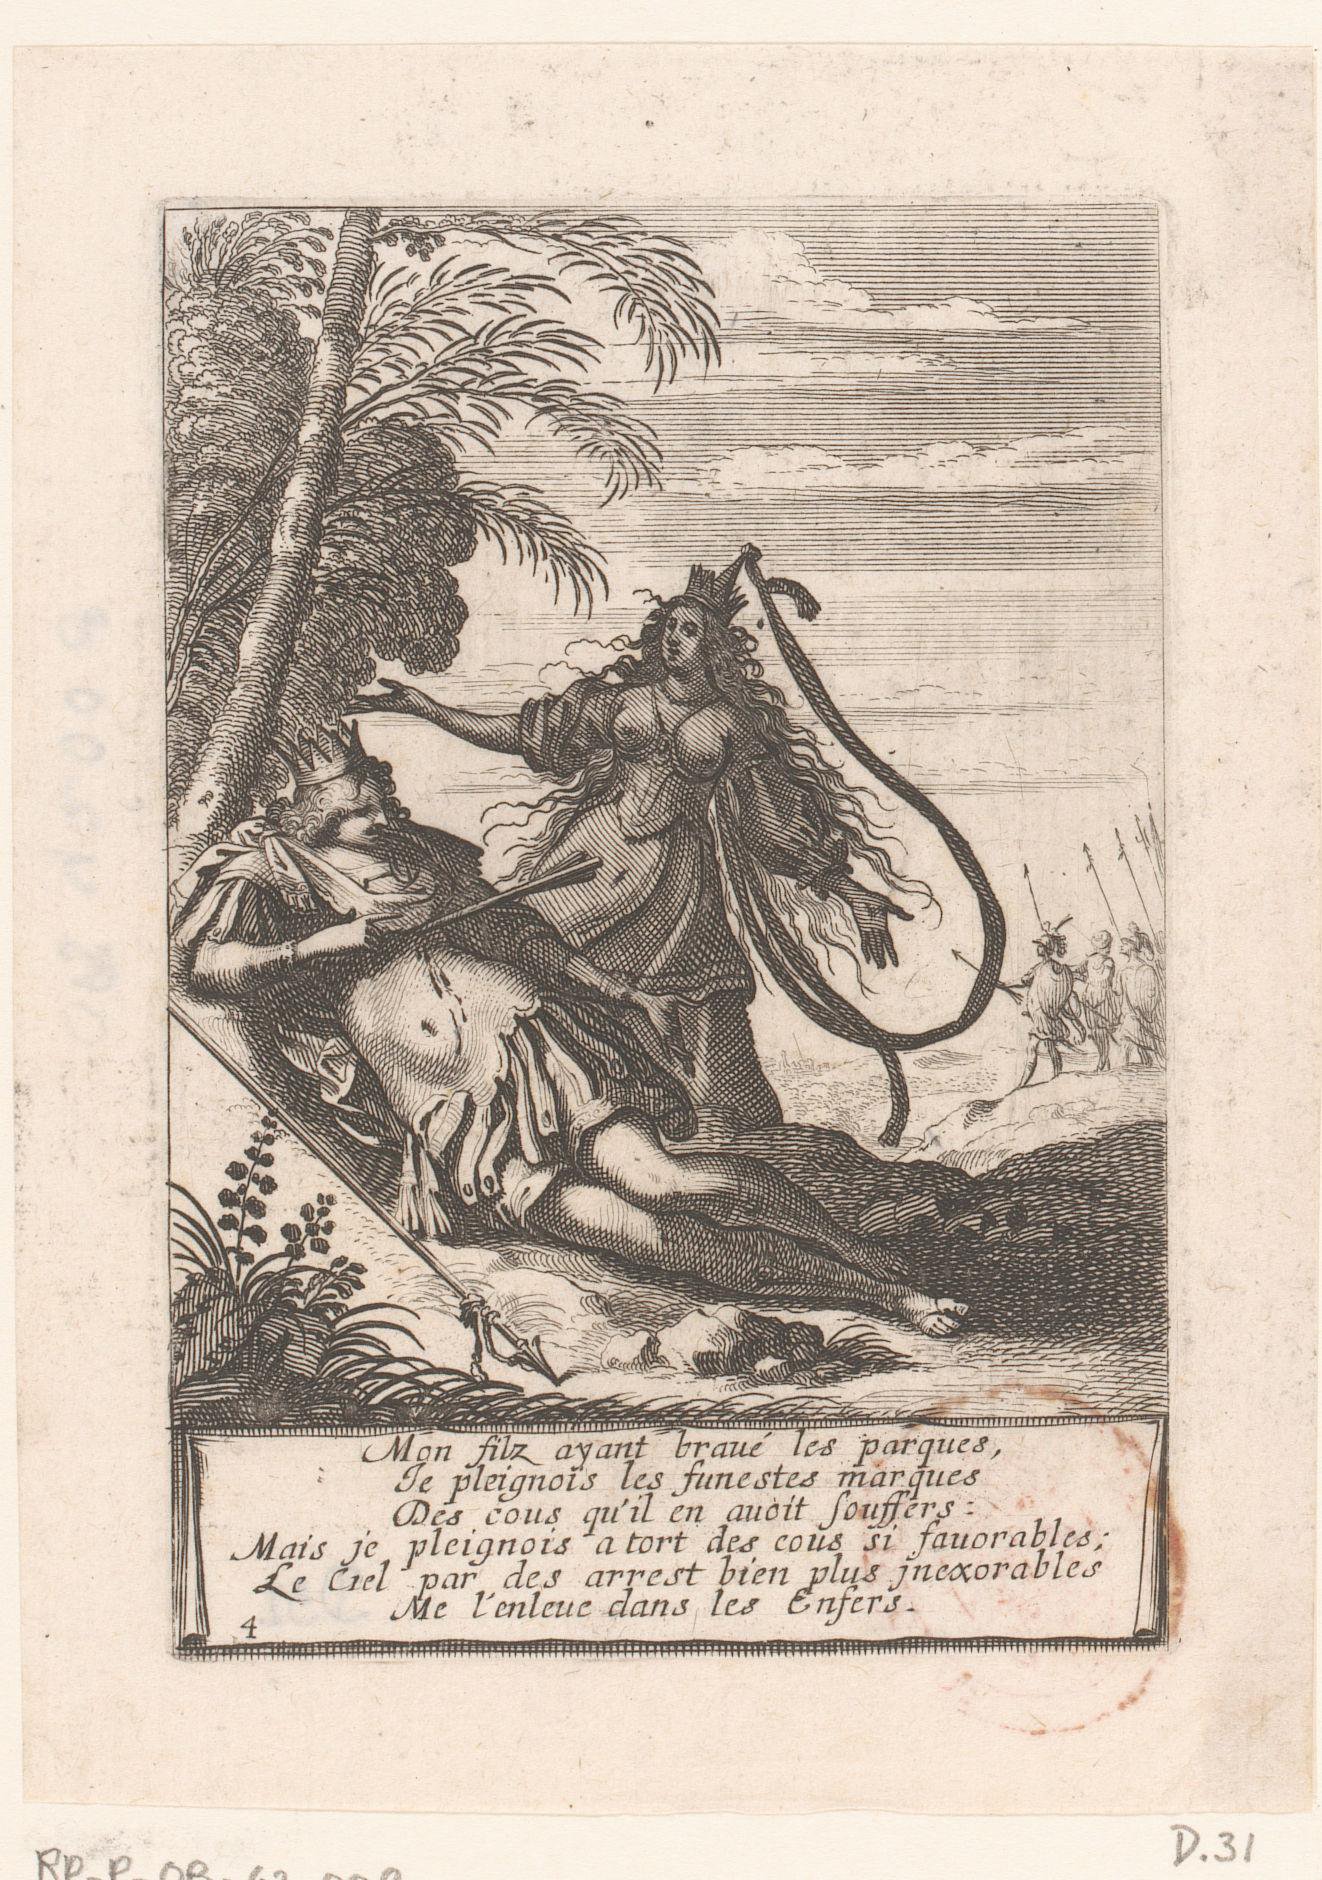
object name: book illustration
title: Koning Joram door een pijl doorboord, Izebel staat naast hem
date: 1635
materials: paper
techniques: engraving, etching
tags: death of jehoram of israel and of ahaziah of judah (2 kings 9:14-29)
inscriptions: collector's mark: Lugt 240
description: Prent uit: Bosse, Abraham. Jezabel ou l'Impieté punie. Rouen: College royal et archiepiscopal de Bourbon de la Compagnie de Jesus, 1635.